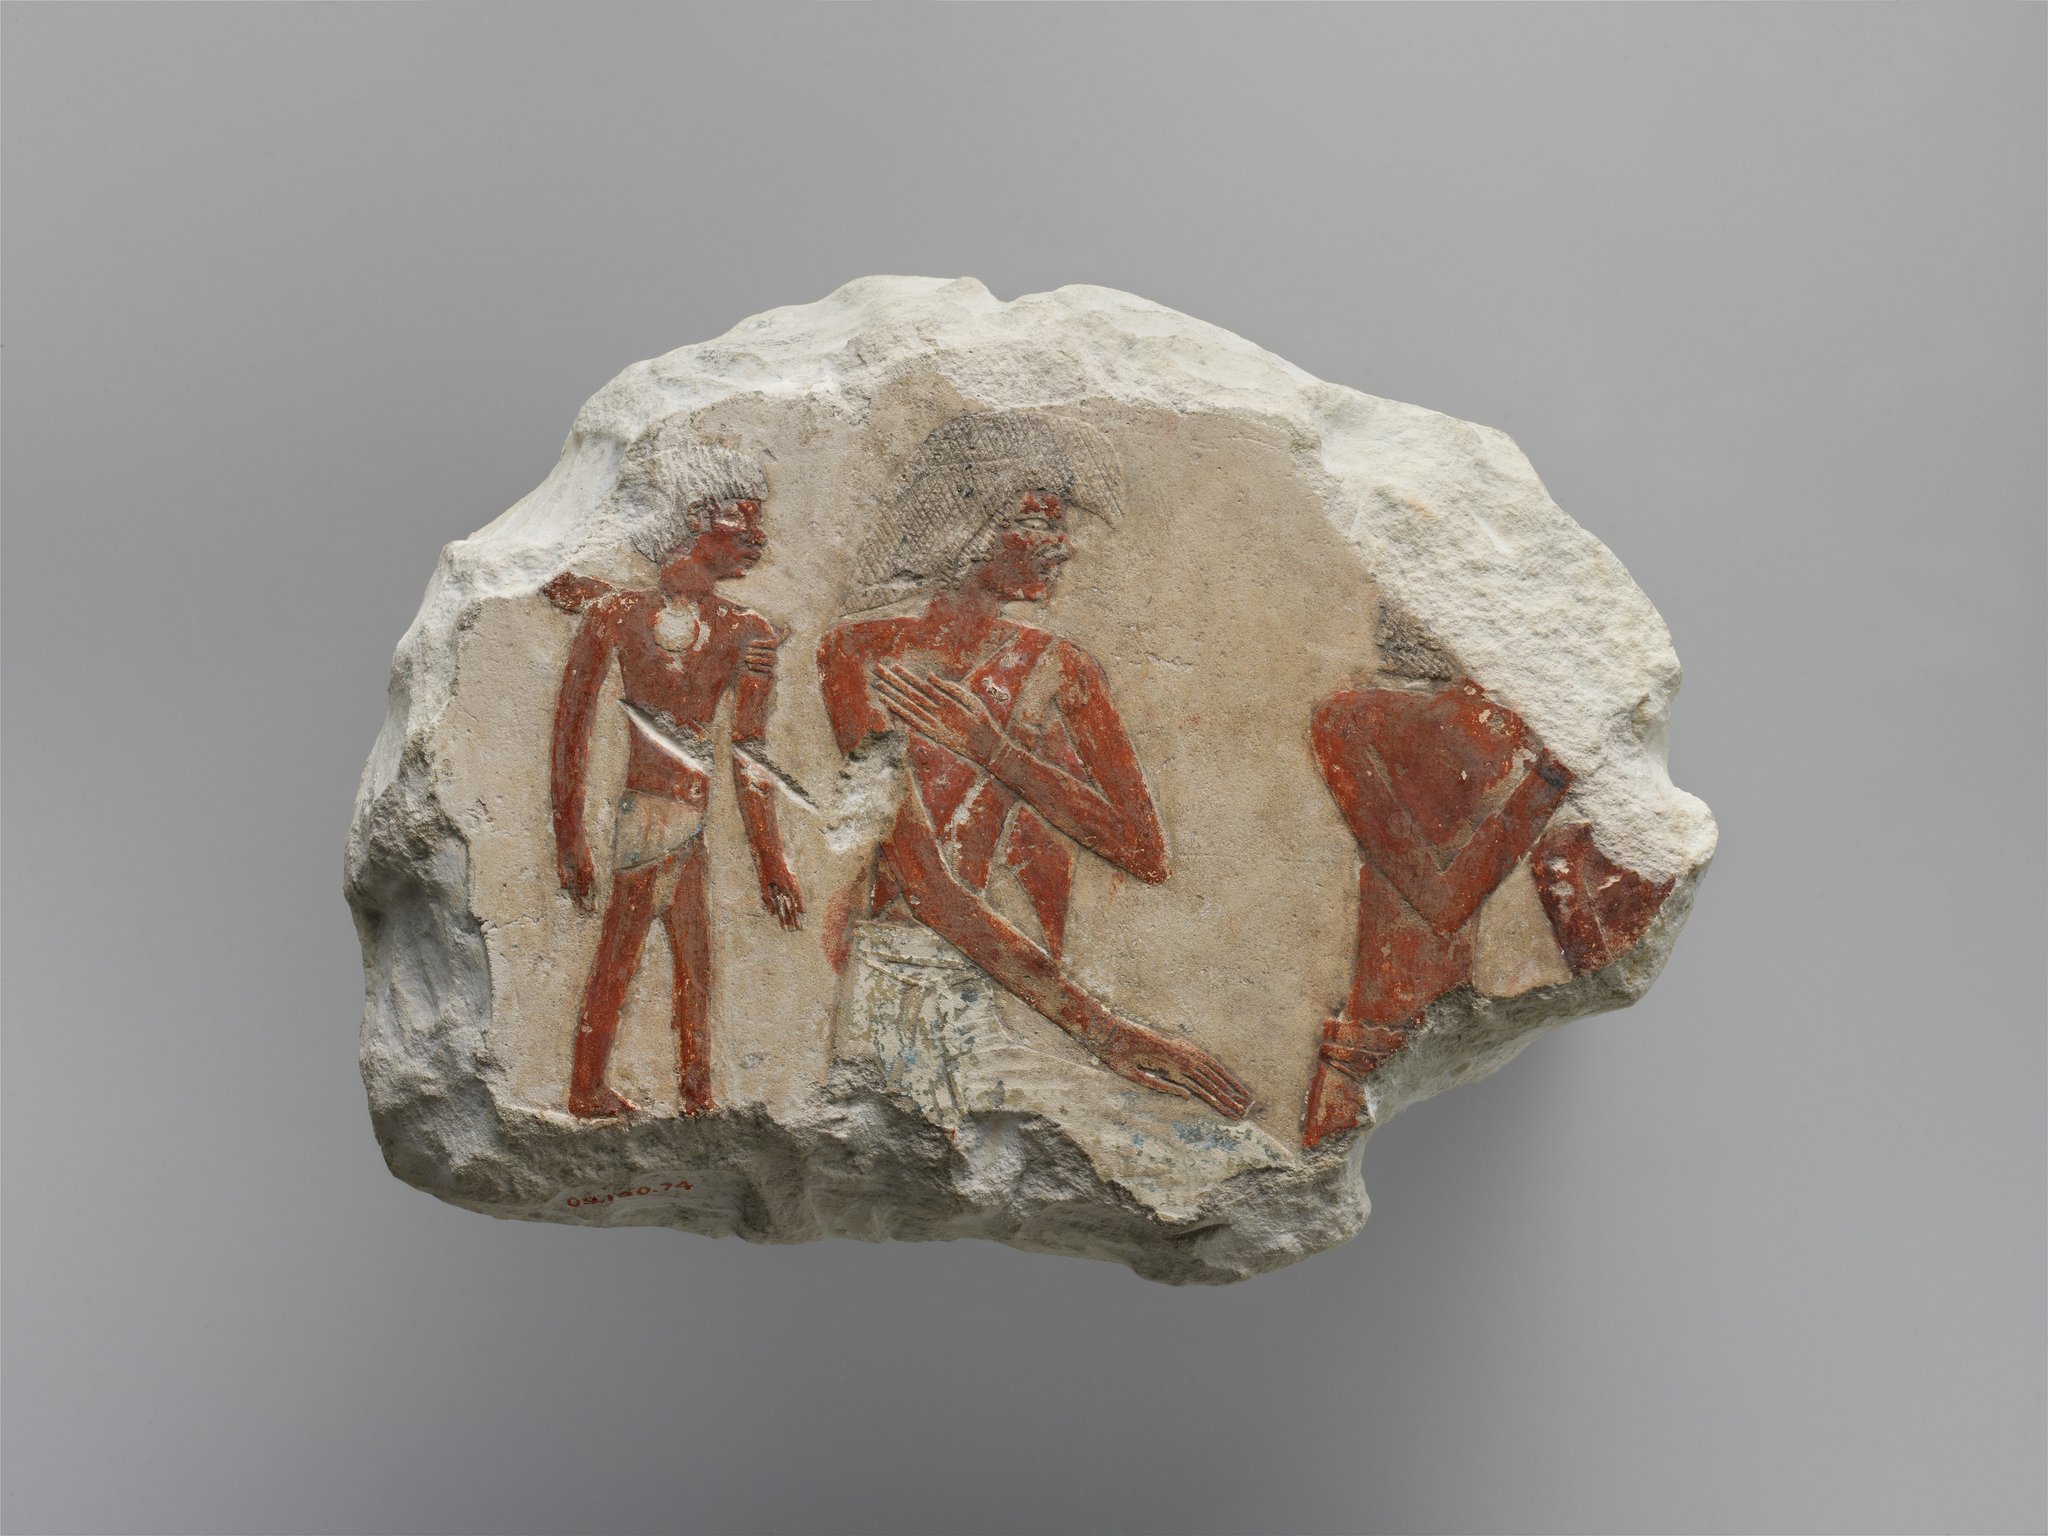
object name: relief fragment, senwosret i temple, foreigner, child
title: Fragments depicting a group of foreigners including a child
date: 1961-1917 BCE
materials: limestone, paint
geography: egypt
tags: human figures